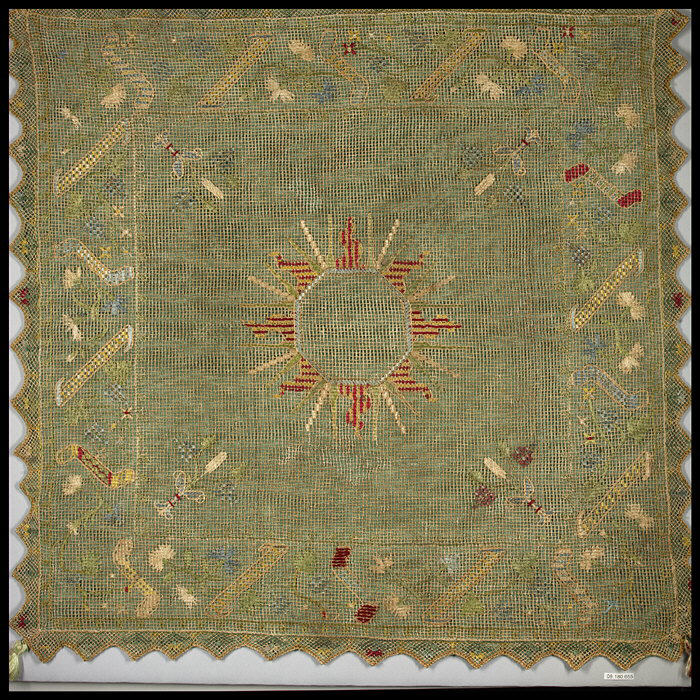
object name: square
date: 1701-1800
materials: silk